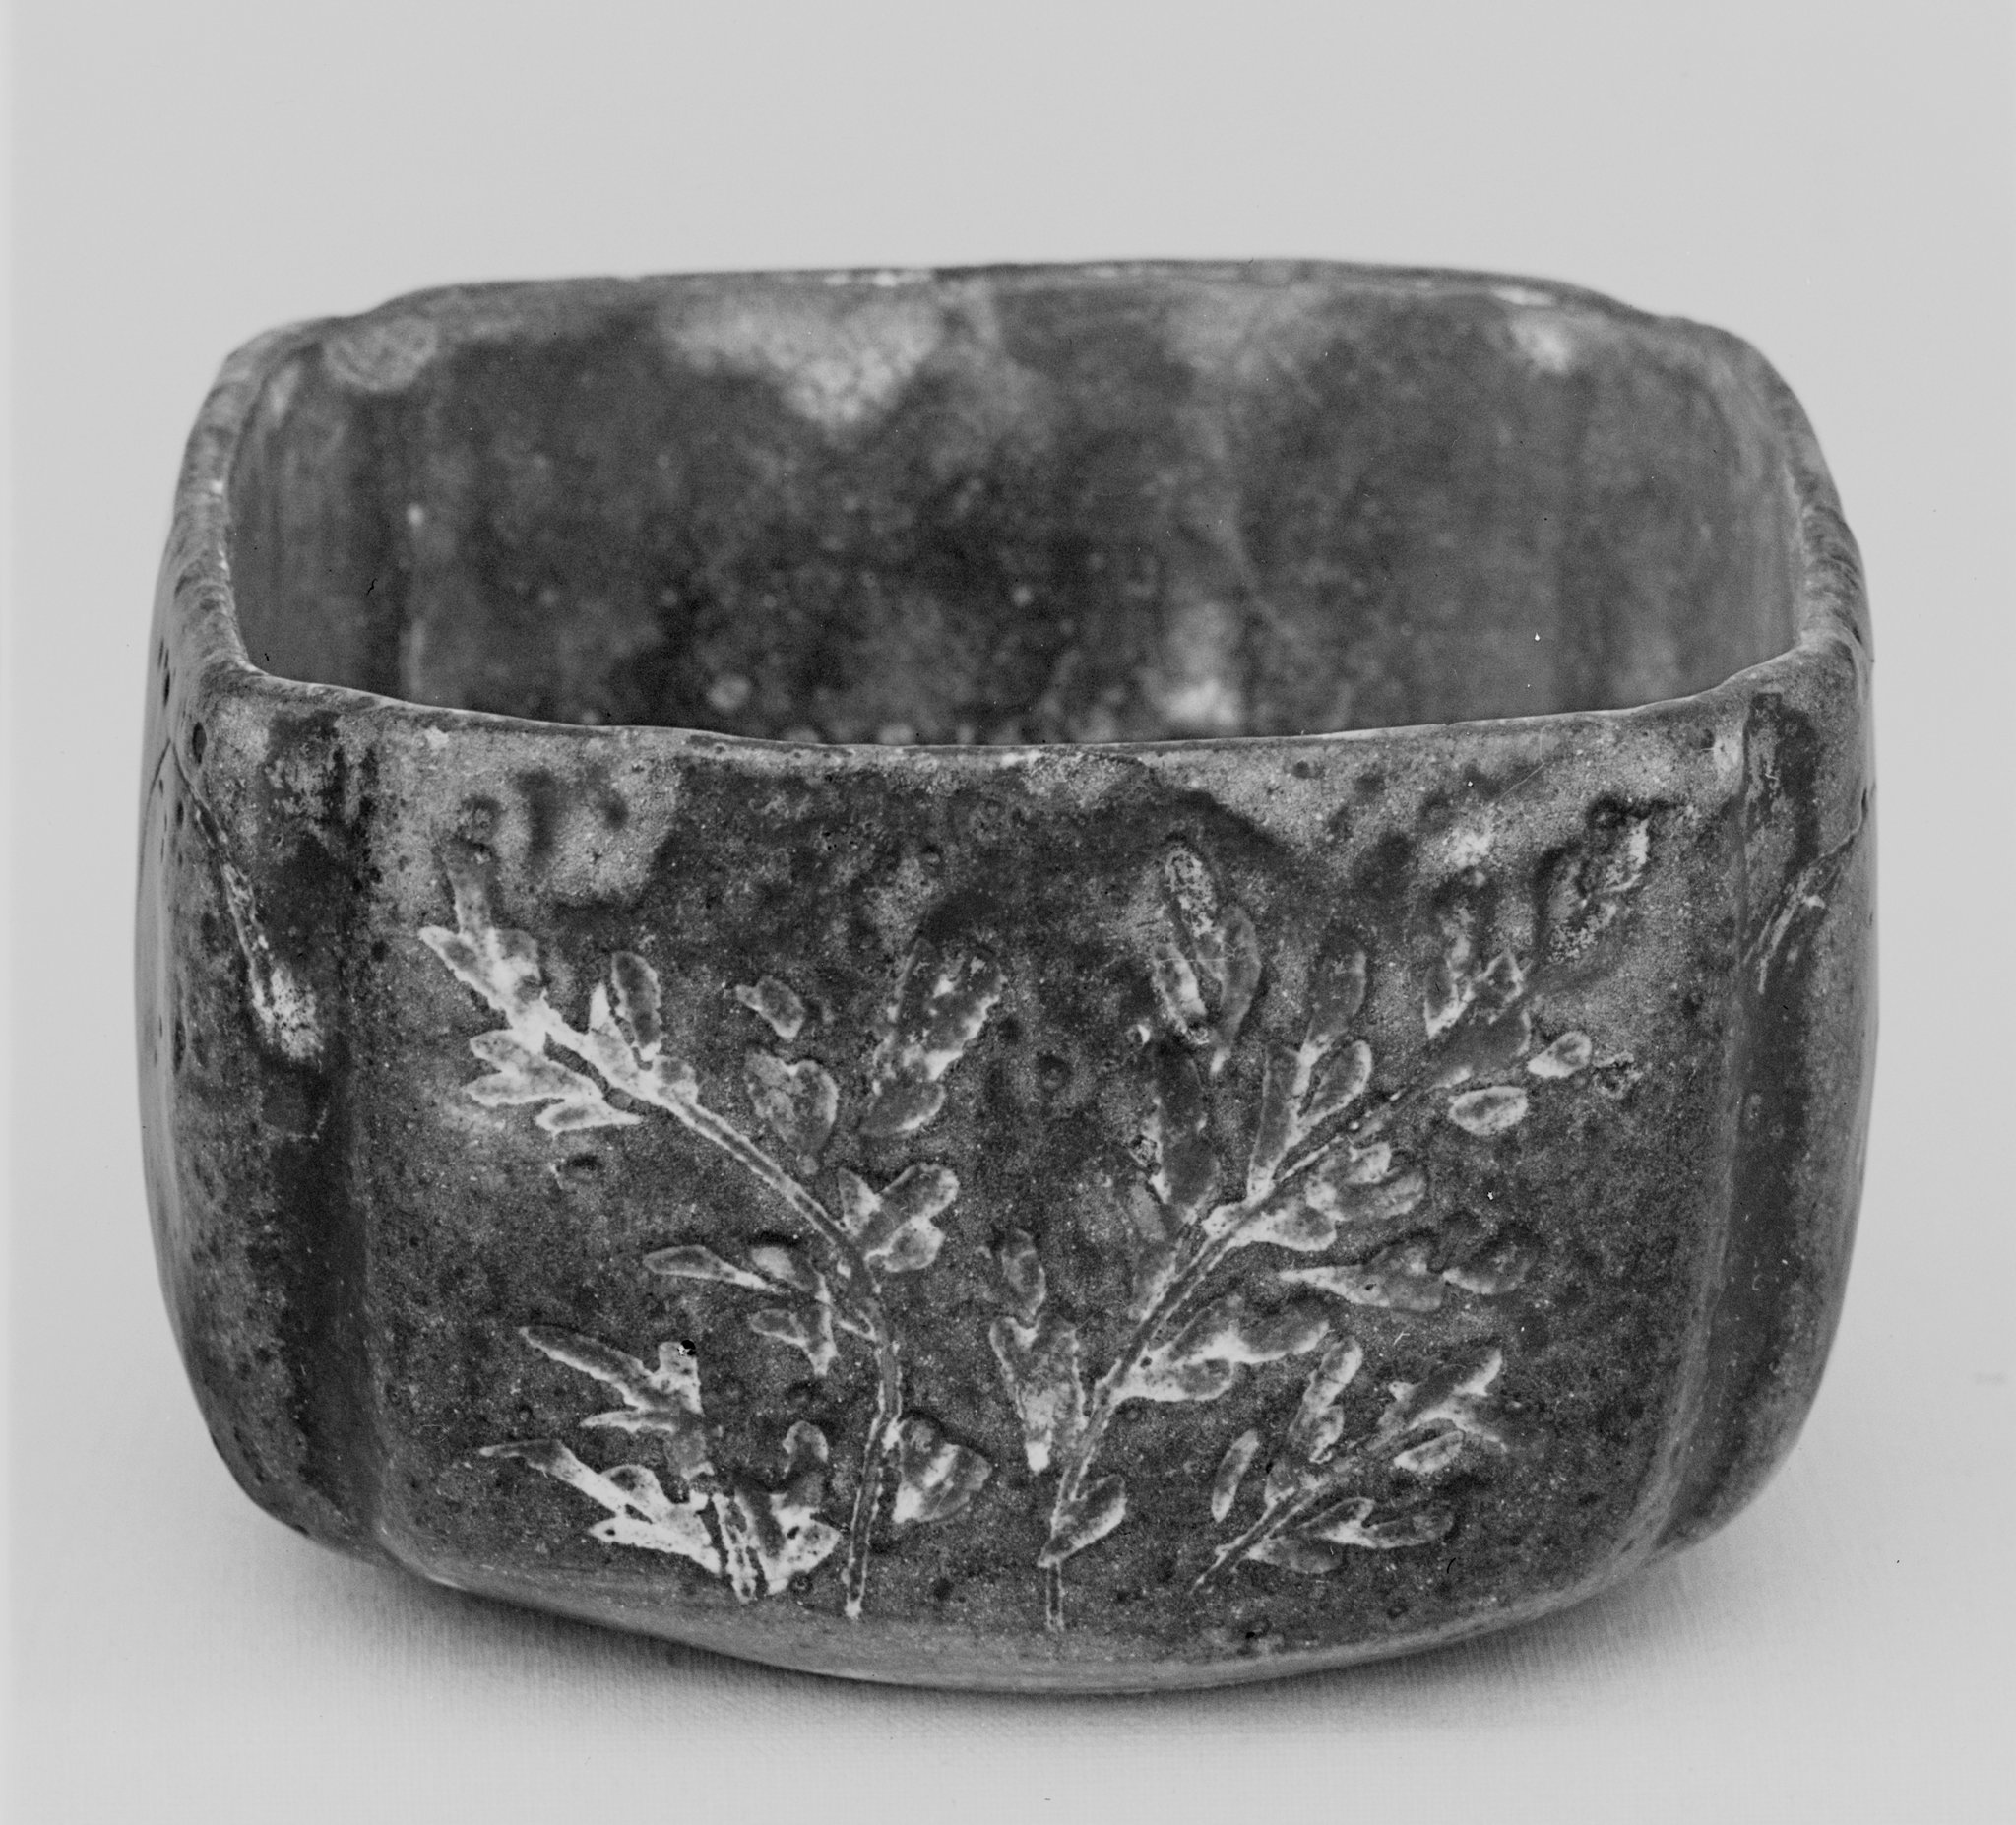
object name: bowl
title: Square Bowl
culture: japanese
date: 1701-1800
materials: clay, glaze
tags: leaves